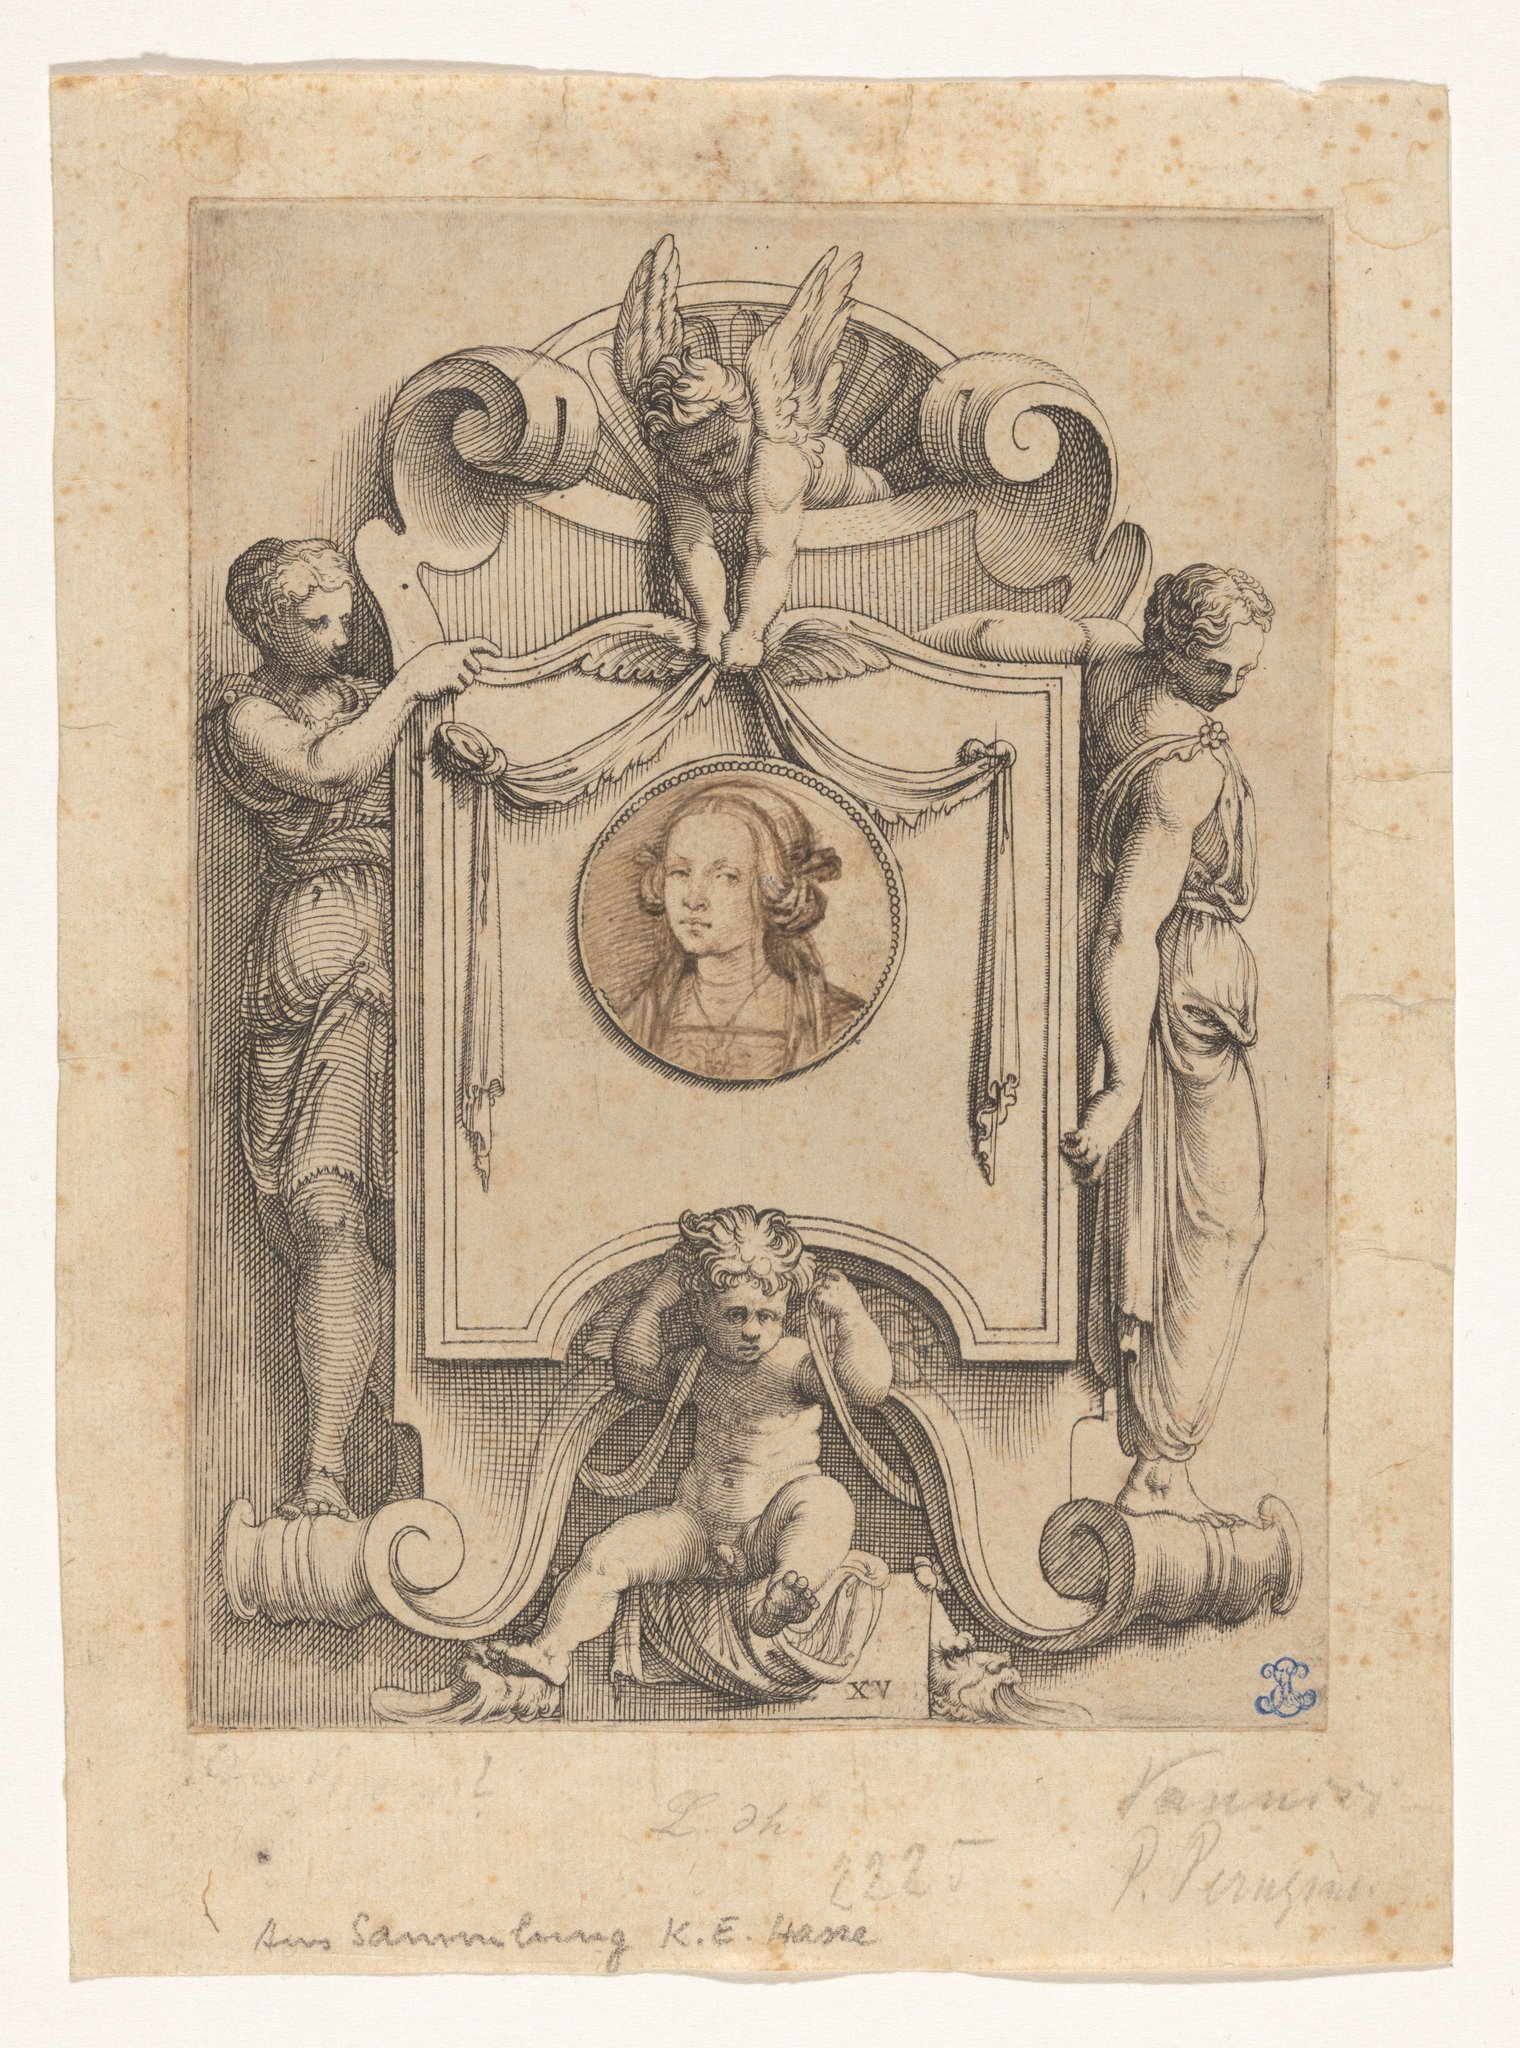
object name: drawing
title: Portret van een jonge vrouw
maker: Anonymous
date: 1530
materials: ink, paper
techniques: engraving, pen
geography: italy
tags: anonymous historical person portrayed - bb - woman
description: The woman in this delicate portrait must have been important enough to have her features immortalized and set in such a beautiful ornamental frame. Was she an actual person or an idealized historical figure? The Roman numerals, at lower centre, suggest it was probably part of a series of similar intimate portraits on paper, compiled and treasured by collectors from the Renaissance.